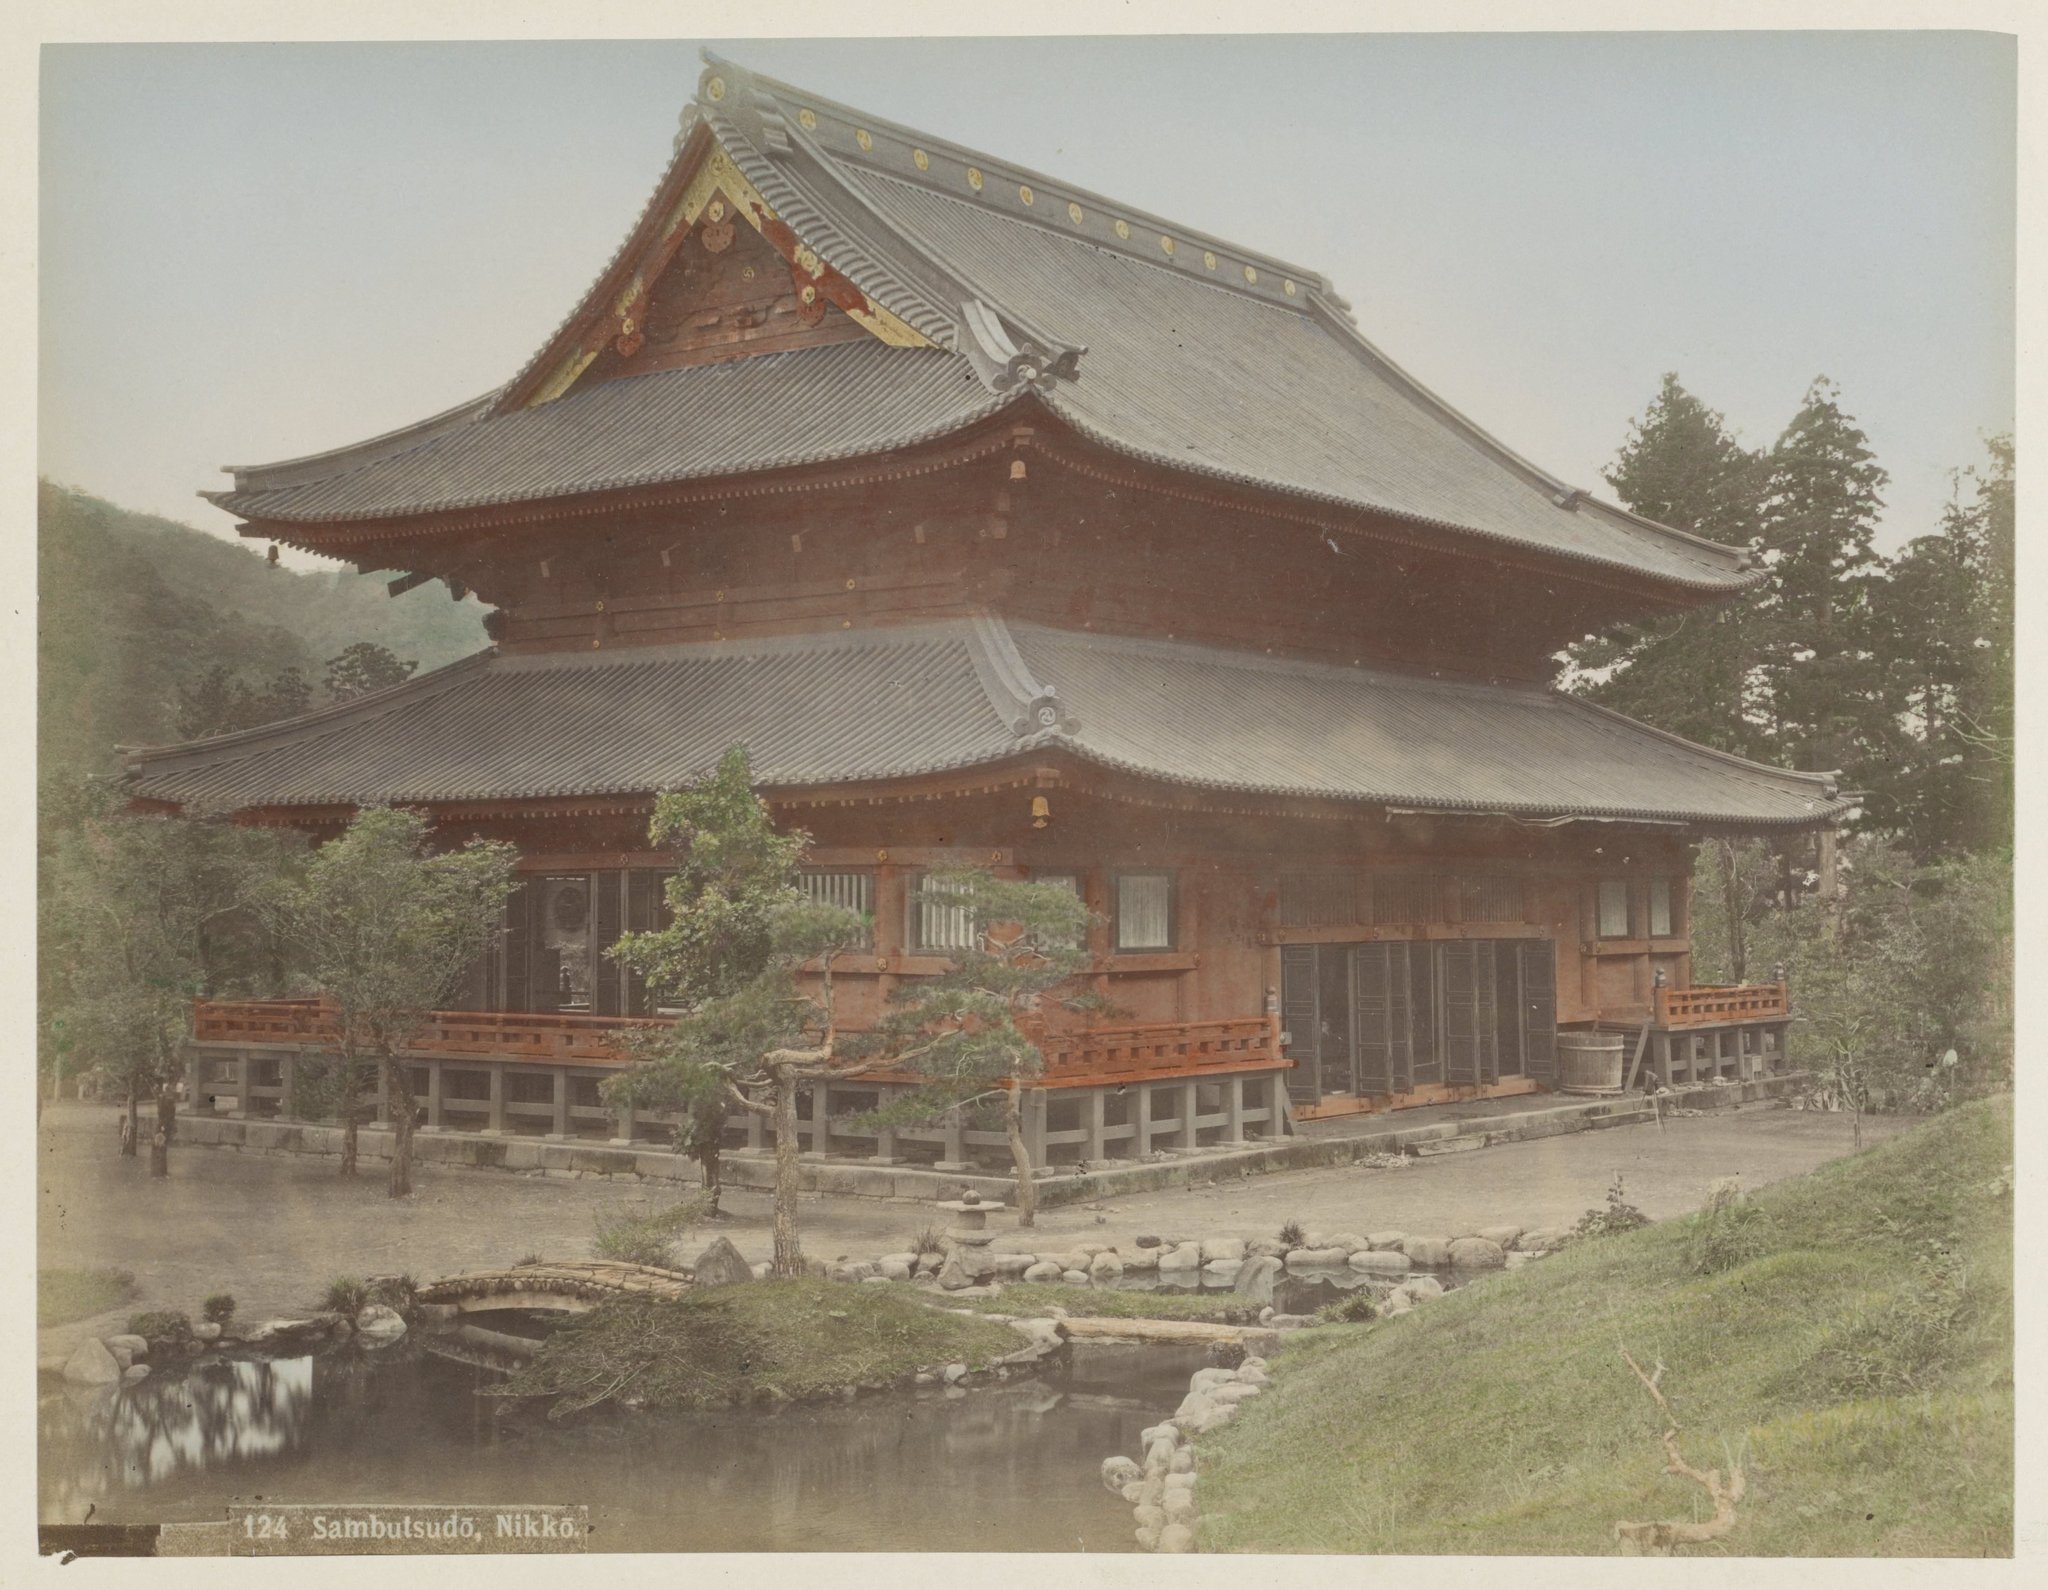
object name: photograph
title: Exterieur van Sanbutsudo, het hoofdgebouw van het Rinnoji-tempelcomplex in Nikko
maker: Anonymous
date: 1870-1900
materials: paper, photographic support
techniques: albumen print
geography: nikko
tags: temple, shrine ~ hinduism, buddhism, jainism, roof (of house or building), travelling; tourism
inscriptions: negative number: ‘124’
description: Onderdeel van Fotoalbum met 50 foto's van bezienswaardigheden in Japan.